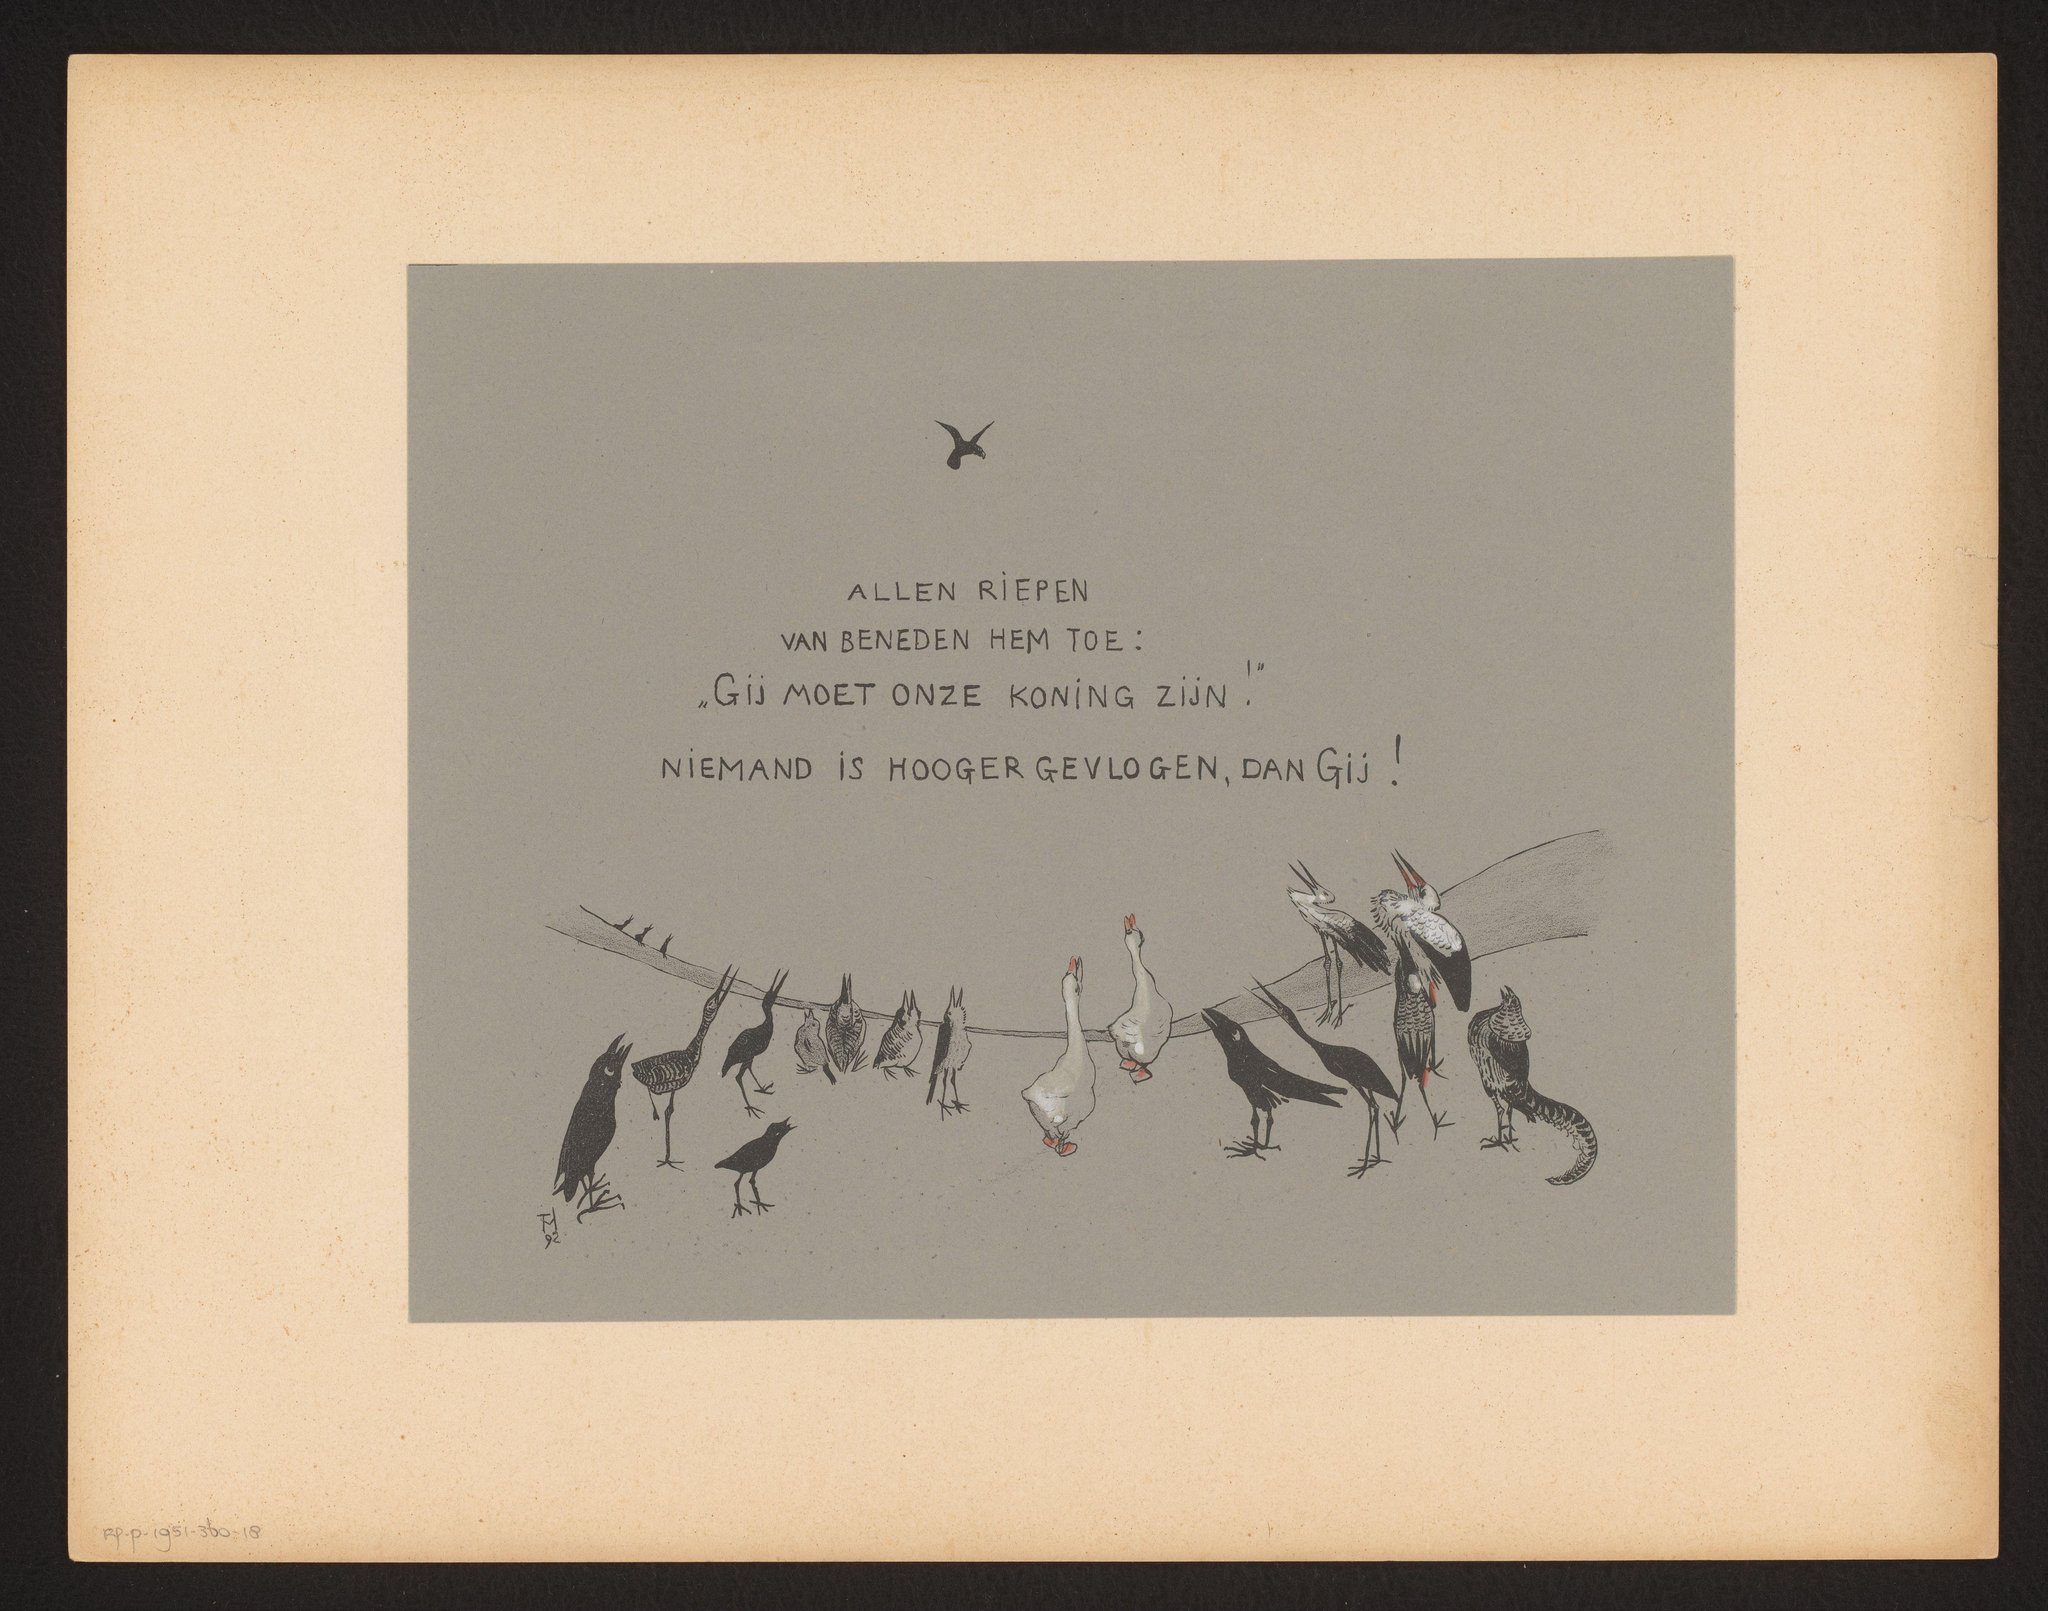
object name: print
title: Vanaf de grond kijkt een groep vogels op naar een biddende arend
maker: theo van hoytema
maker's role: draughtsman, painter, print maker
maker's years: 1863-1917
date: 1892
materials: paper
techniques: hand coloring, lithograph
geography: the hague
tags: predatory birds: eagle, water-birds: goose, shore-birds and wading-birds: stork, walker and runner birds: pheasant, groups of birds, shore-birds and wading-birds: bittern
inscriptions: date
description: Onder andere roerdomp, kraai, fazant, ooievaar en gans.